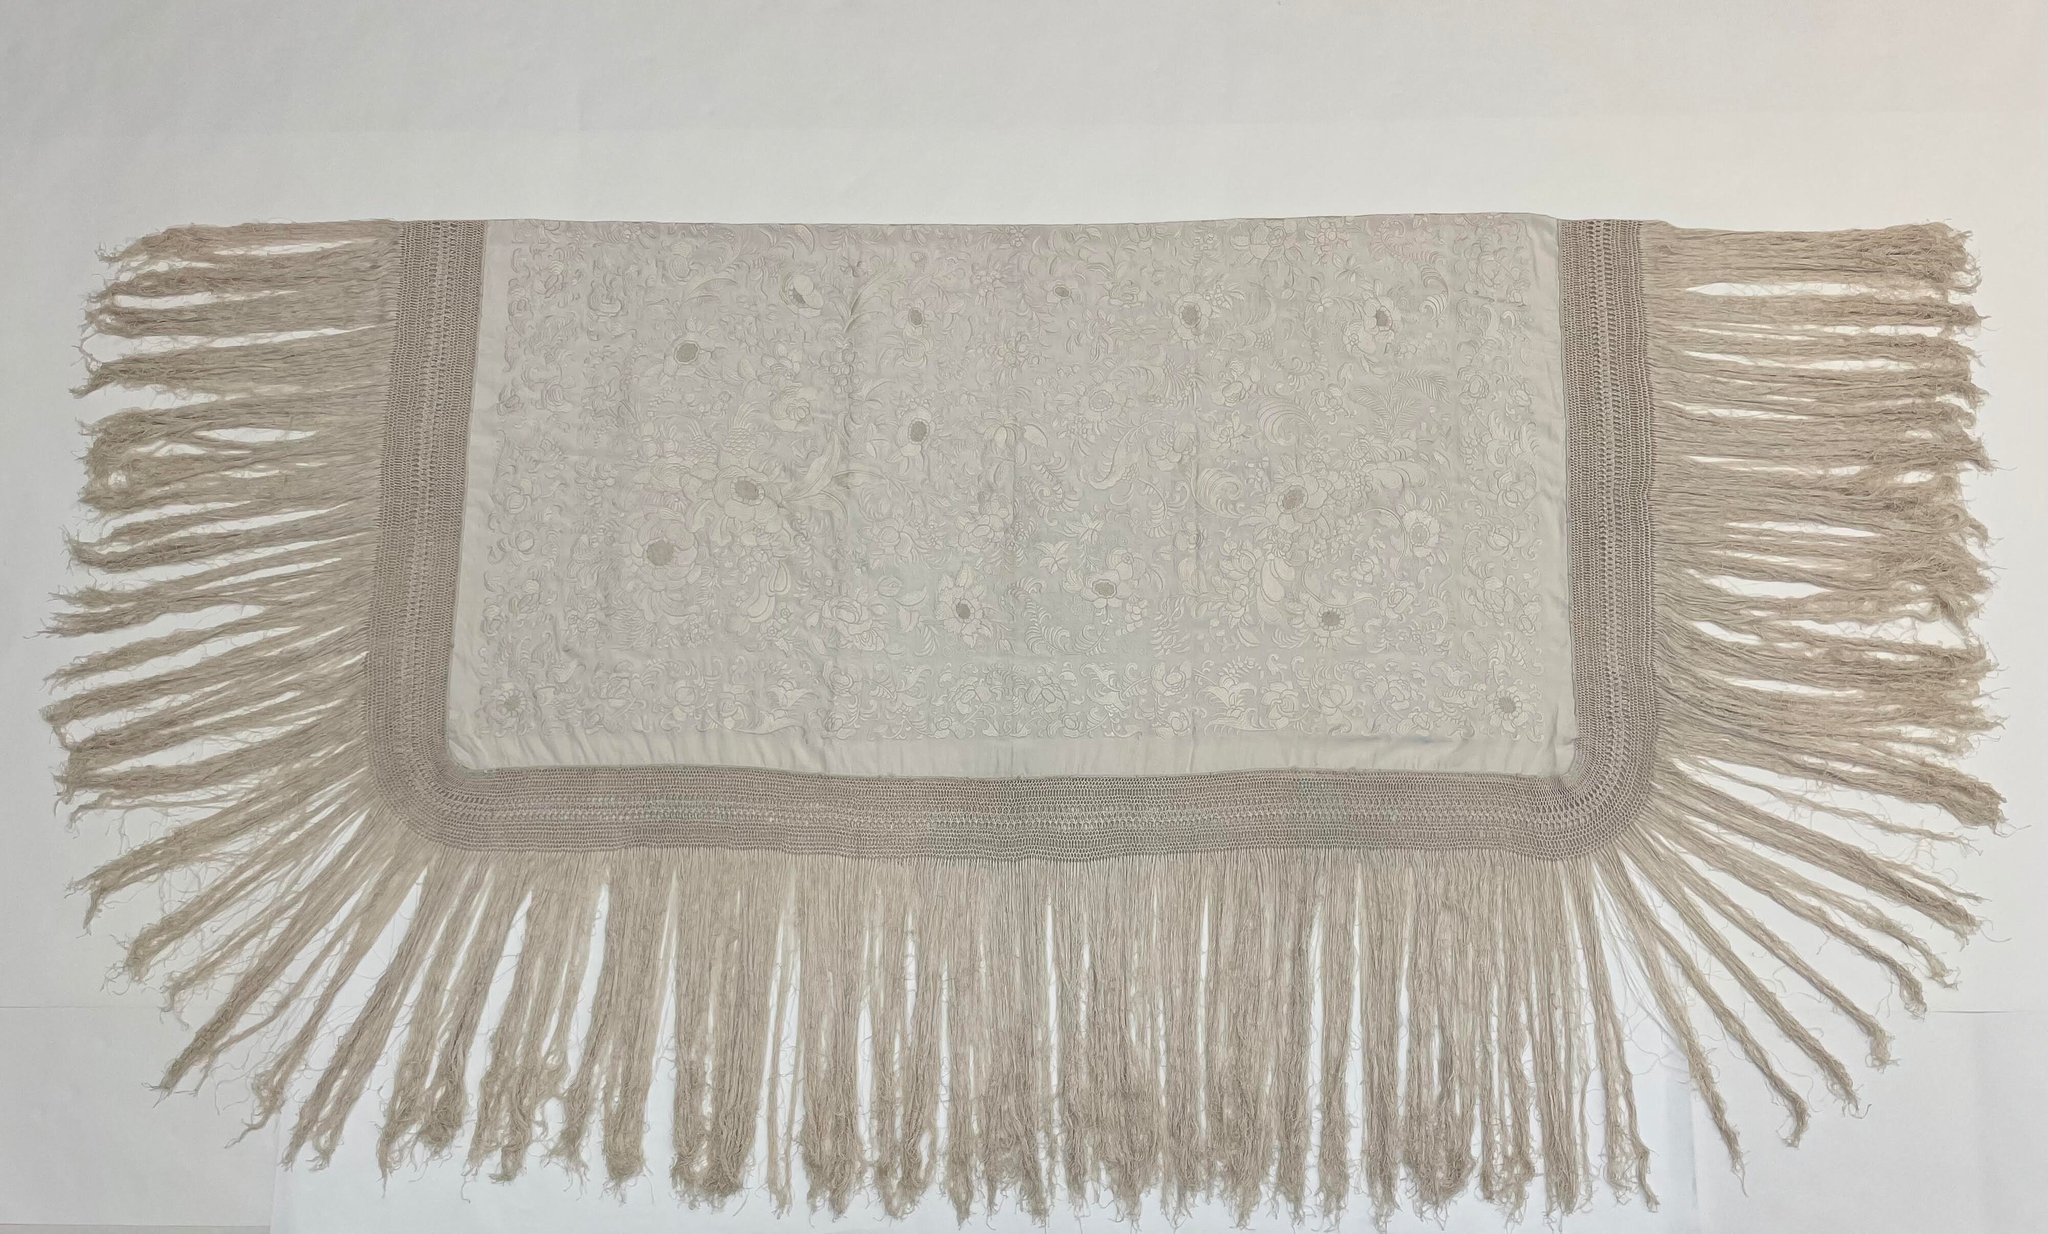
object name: shawl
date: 1834-1866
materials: silk